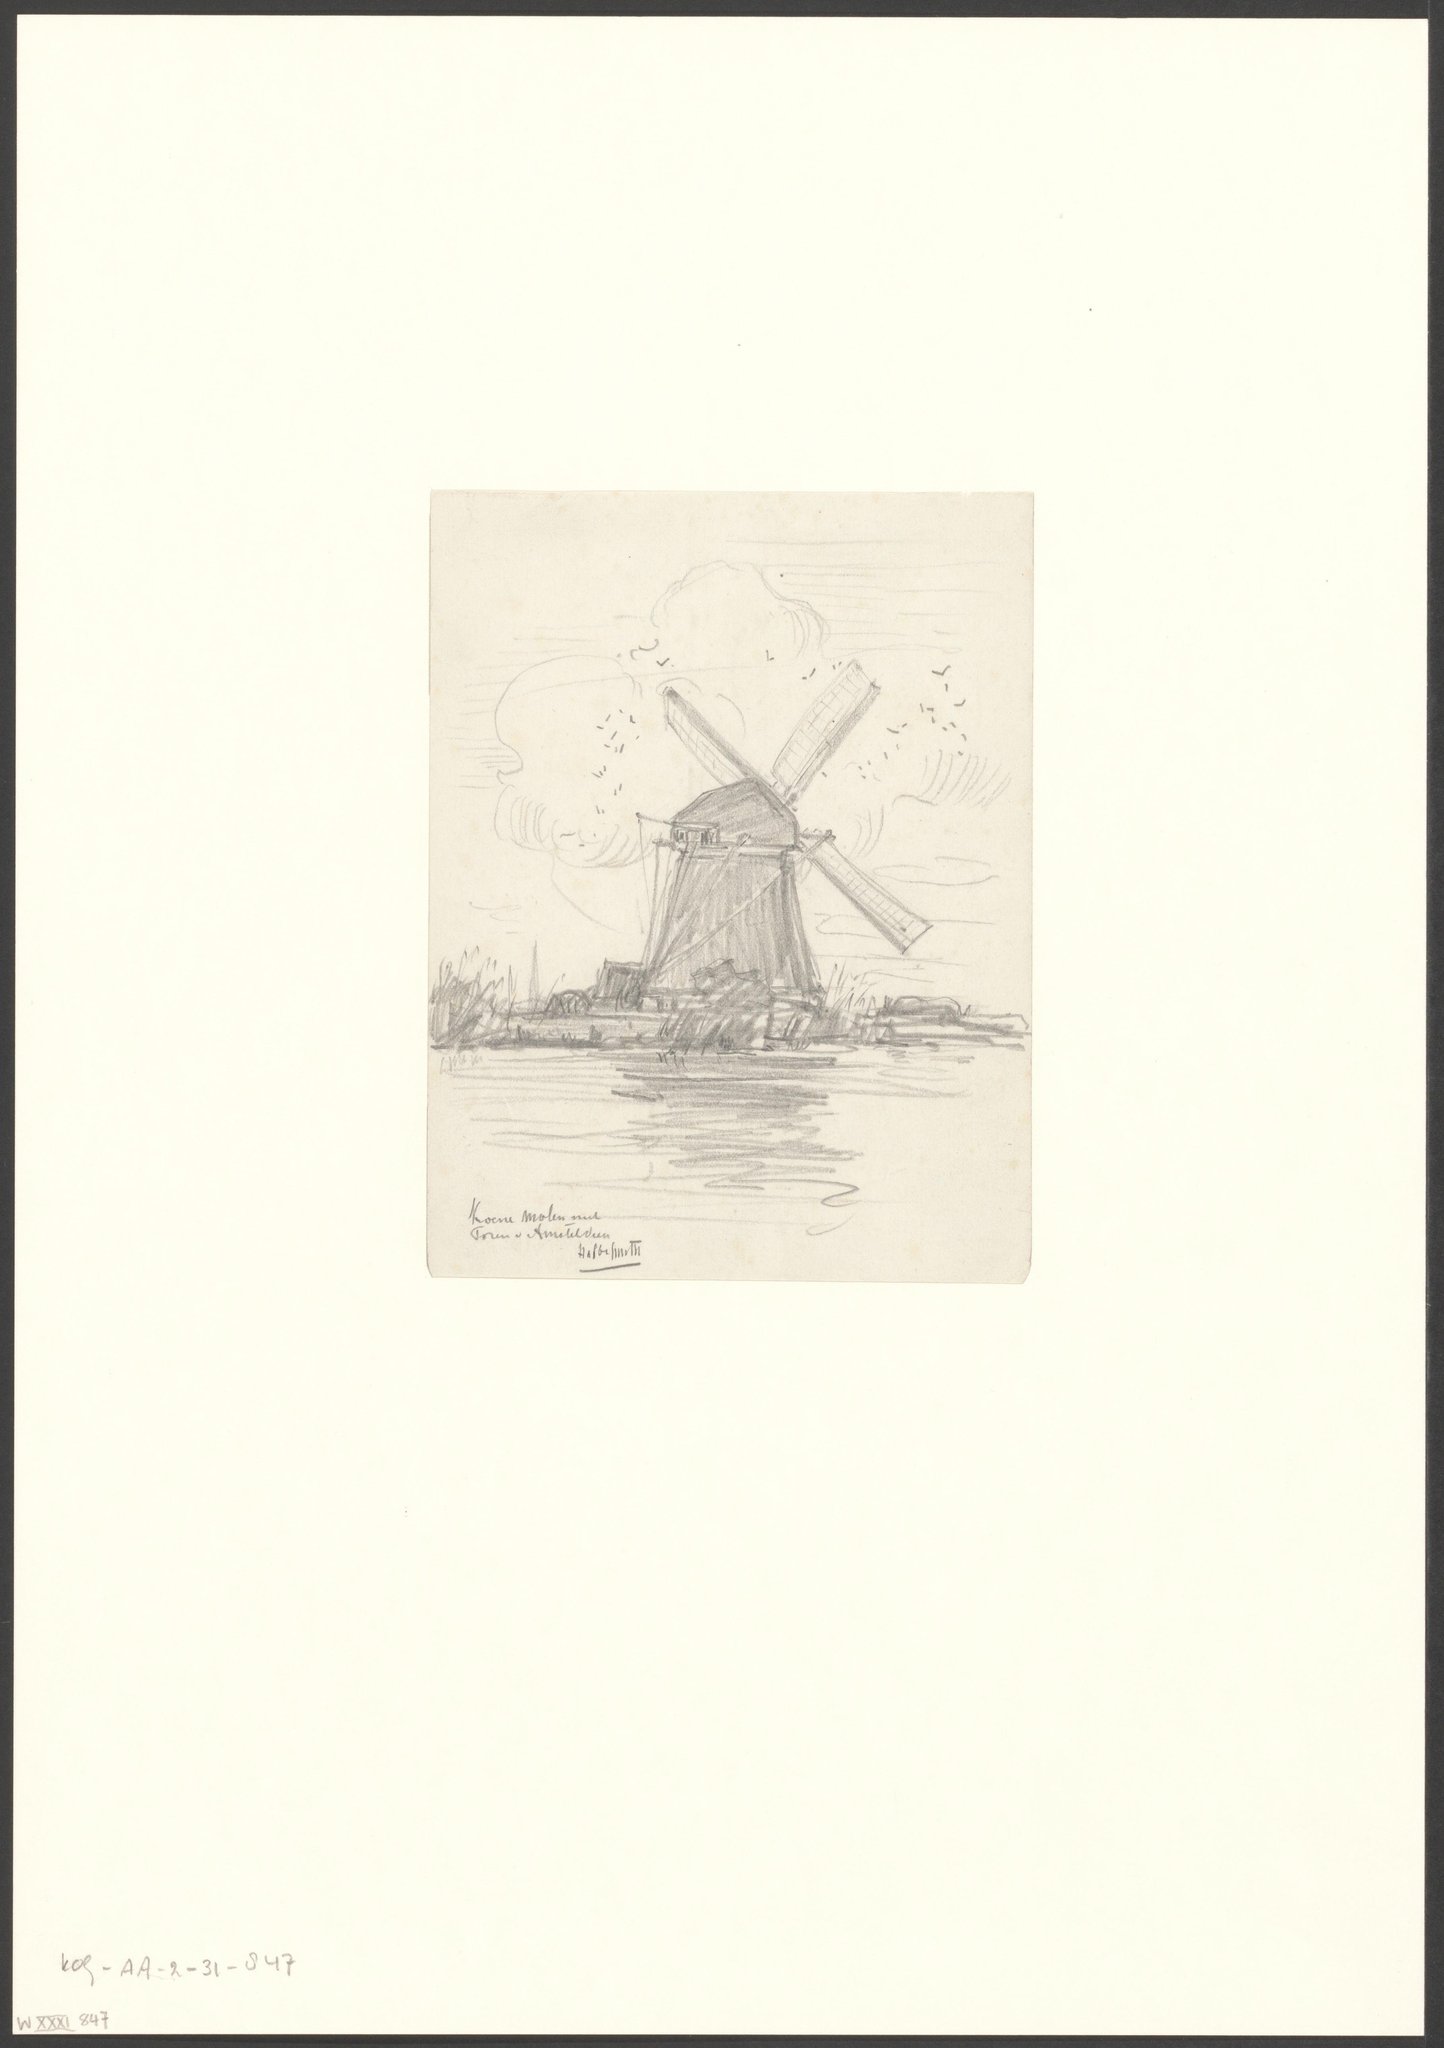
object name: drawing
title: Gezicht op de Koenenmolen aan de Nieuwe Meer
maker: hobbe smith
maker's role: painter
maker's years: 1862-1942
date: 1872-1919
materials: paper, pencil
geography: amsterdam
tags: city-view in general; 'veduta', lake, windmill in landscape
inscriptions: signature: ‘HobbeSmith’, inscription: ‘Koene Molen met / Toren (?) v Amsterdam’, collector's mark: Lugt 800a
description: Tekening binnen de Atlas Van Eck ingedeeld op wijknummer 31.